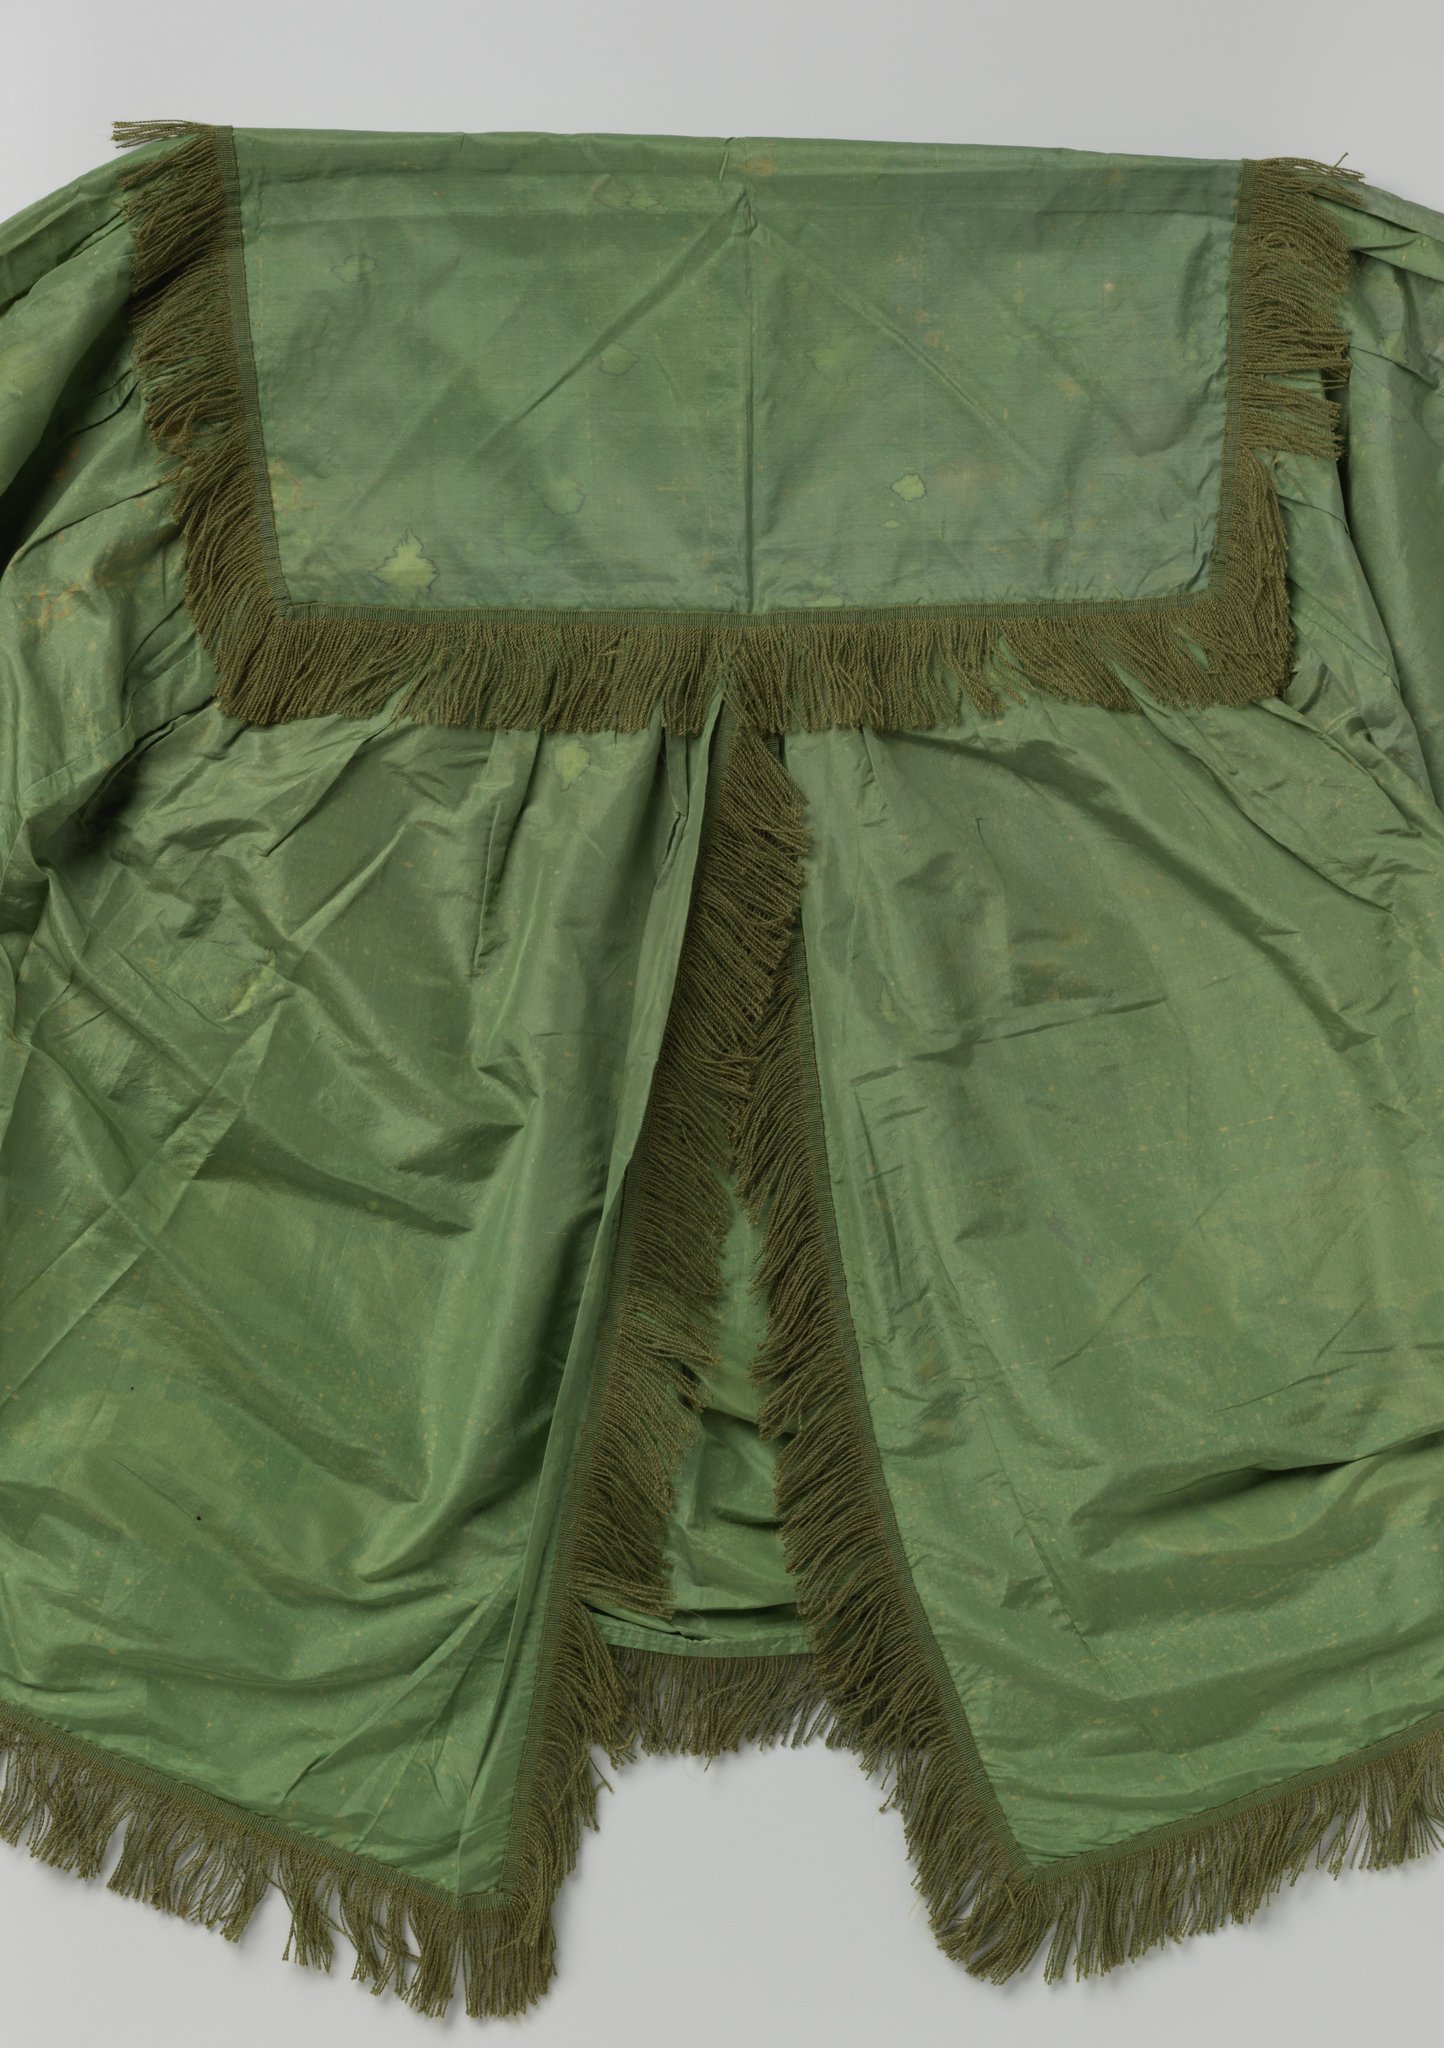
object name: dekkleed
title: Groen afdekkleed met groene wollen franje.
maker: Anonymous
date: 1700-1800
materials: silk, wool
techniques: weave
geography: france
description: Groen afdekkleed (van een vuurmand ?) met groene wollen franje. Bij het afdekkleed wordt een afdekkleed (BK-1992-21-A), een strook (BK-1992-21-C) en een strook franje (BK-1992-21-D) bewaard.